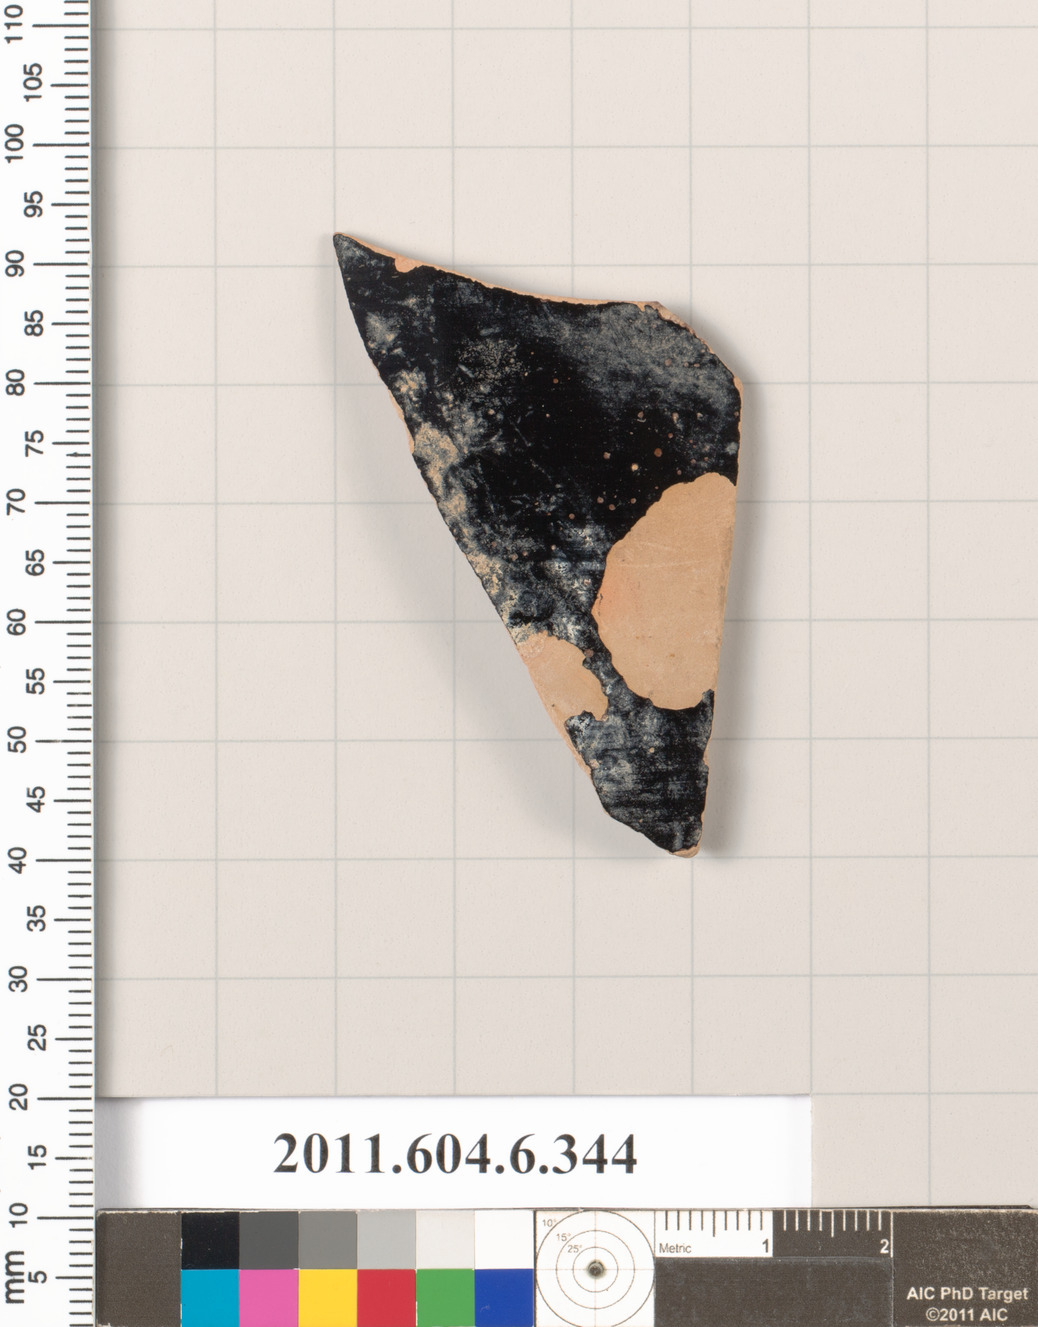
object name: undetermined closed shape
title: Terracotta fragment of a closed shape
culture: greek, attic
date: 600-401 BCE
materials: terracotta